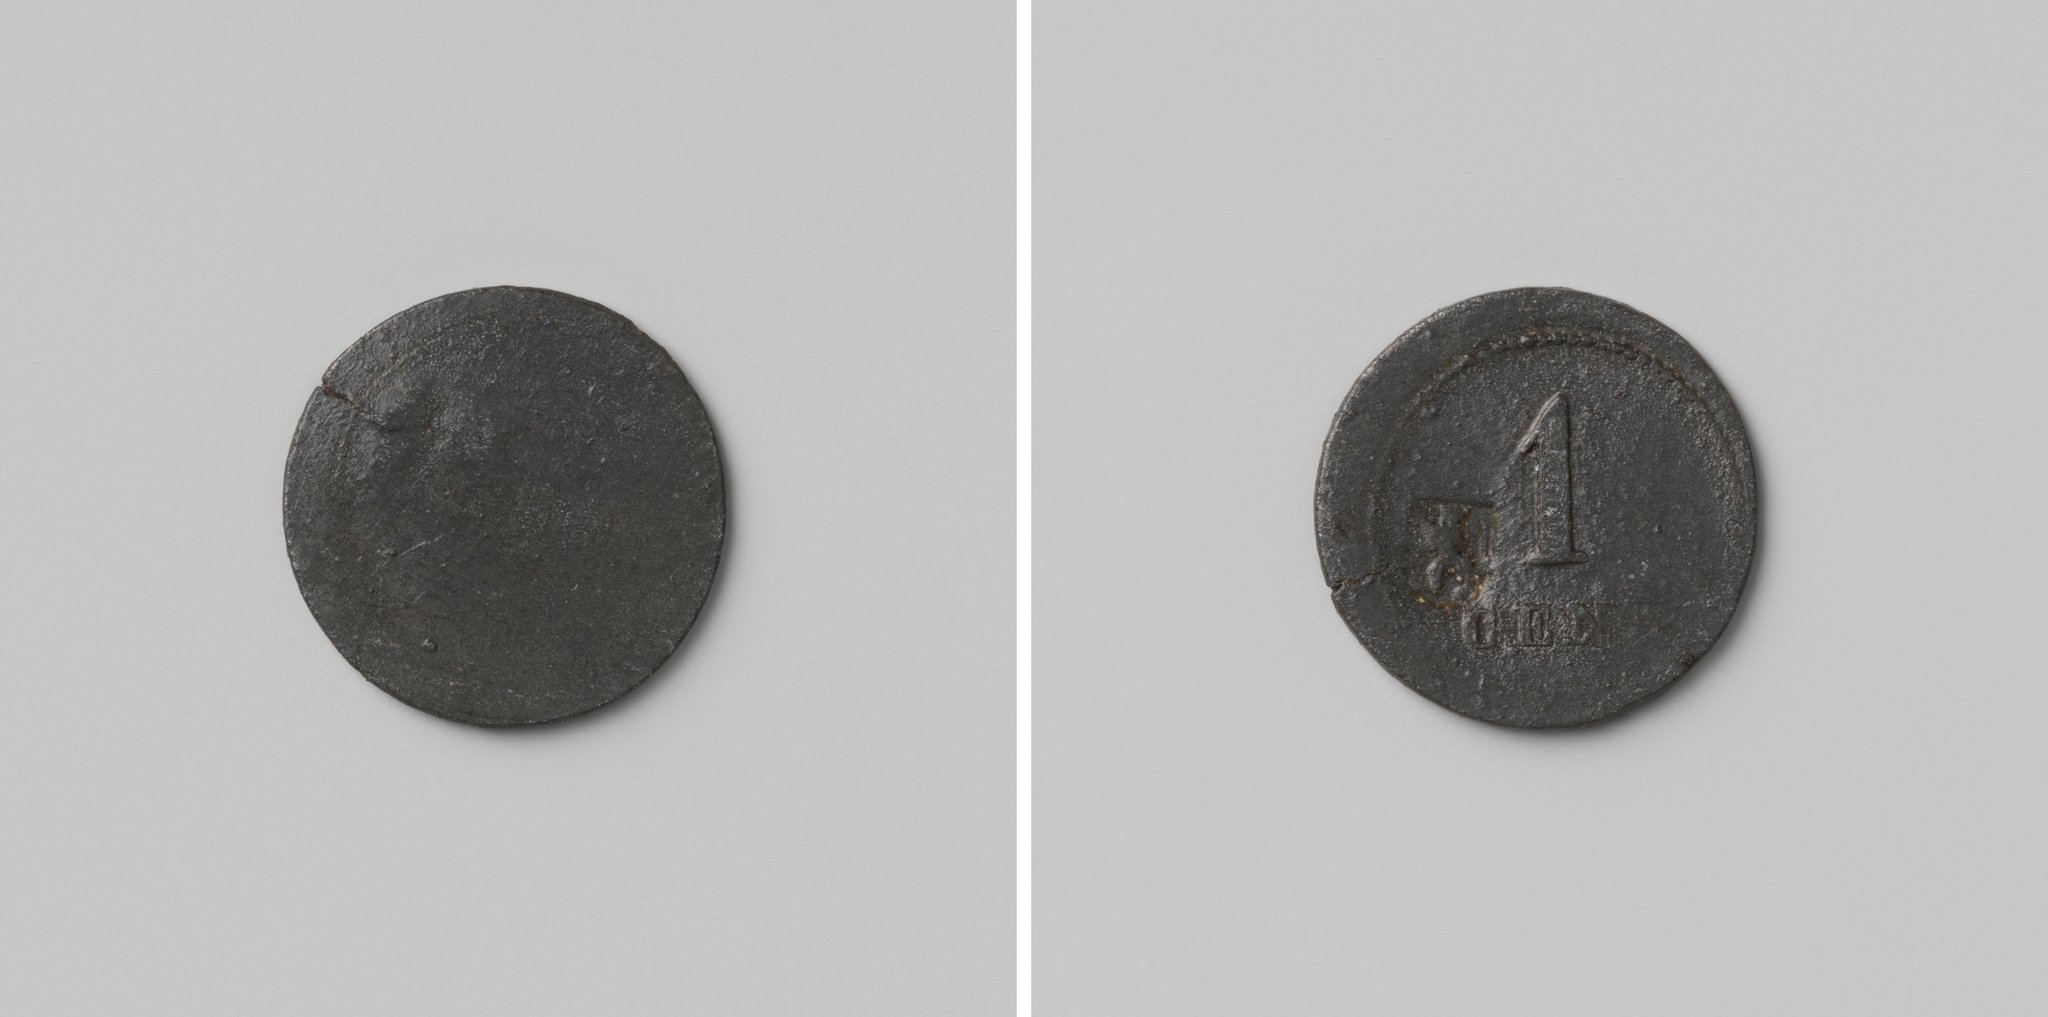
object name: cent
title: Strafgevangenis te Gent, huismunt ter waarde van een cent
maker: Anonymous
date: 1826-1833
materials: zinc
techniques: striking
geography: brussels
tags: ghent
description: Zinken betaalpenning. Voorzijde: opschrift. Keerzijde: waardeaanduiding; links een klop: ingestempeld wapenschild